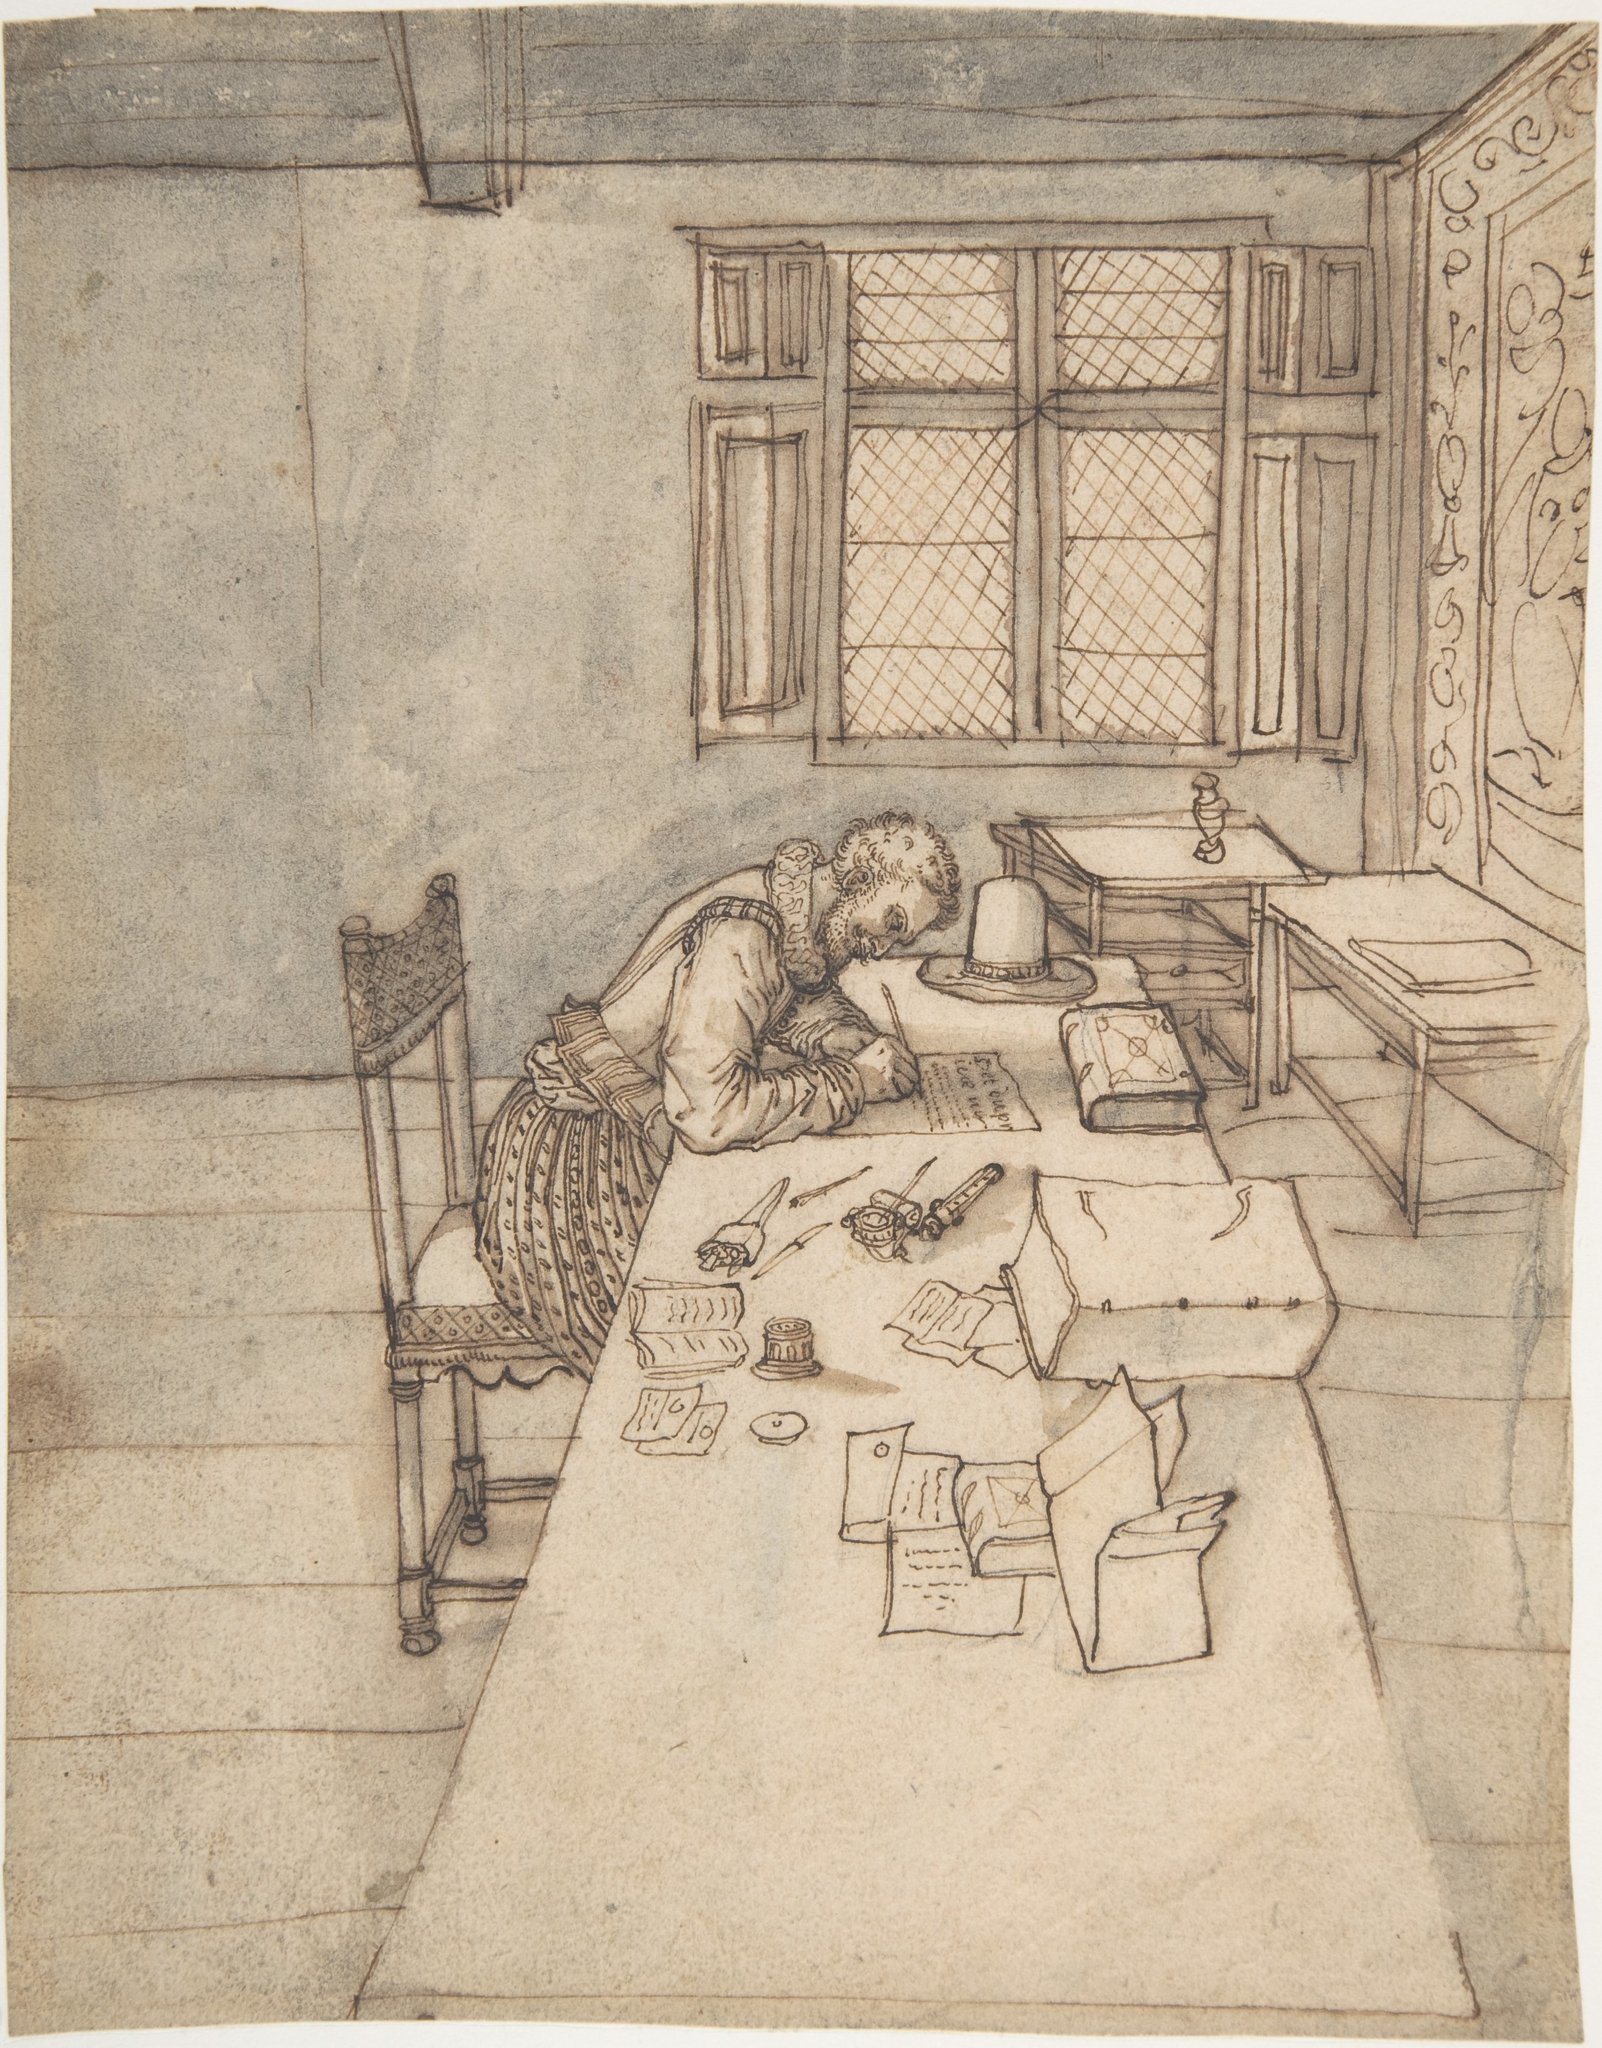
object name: drawing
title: Interior with a Man Writing on a Long Table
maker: anonymous, french, 16th century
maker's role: artist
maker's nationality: french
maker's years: 1500-1600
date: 1501-1600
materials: graphite, ink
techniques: brush, pen, wash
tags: interiors,men,writing,tables